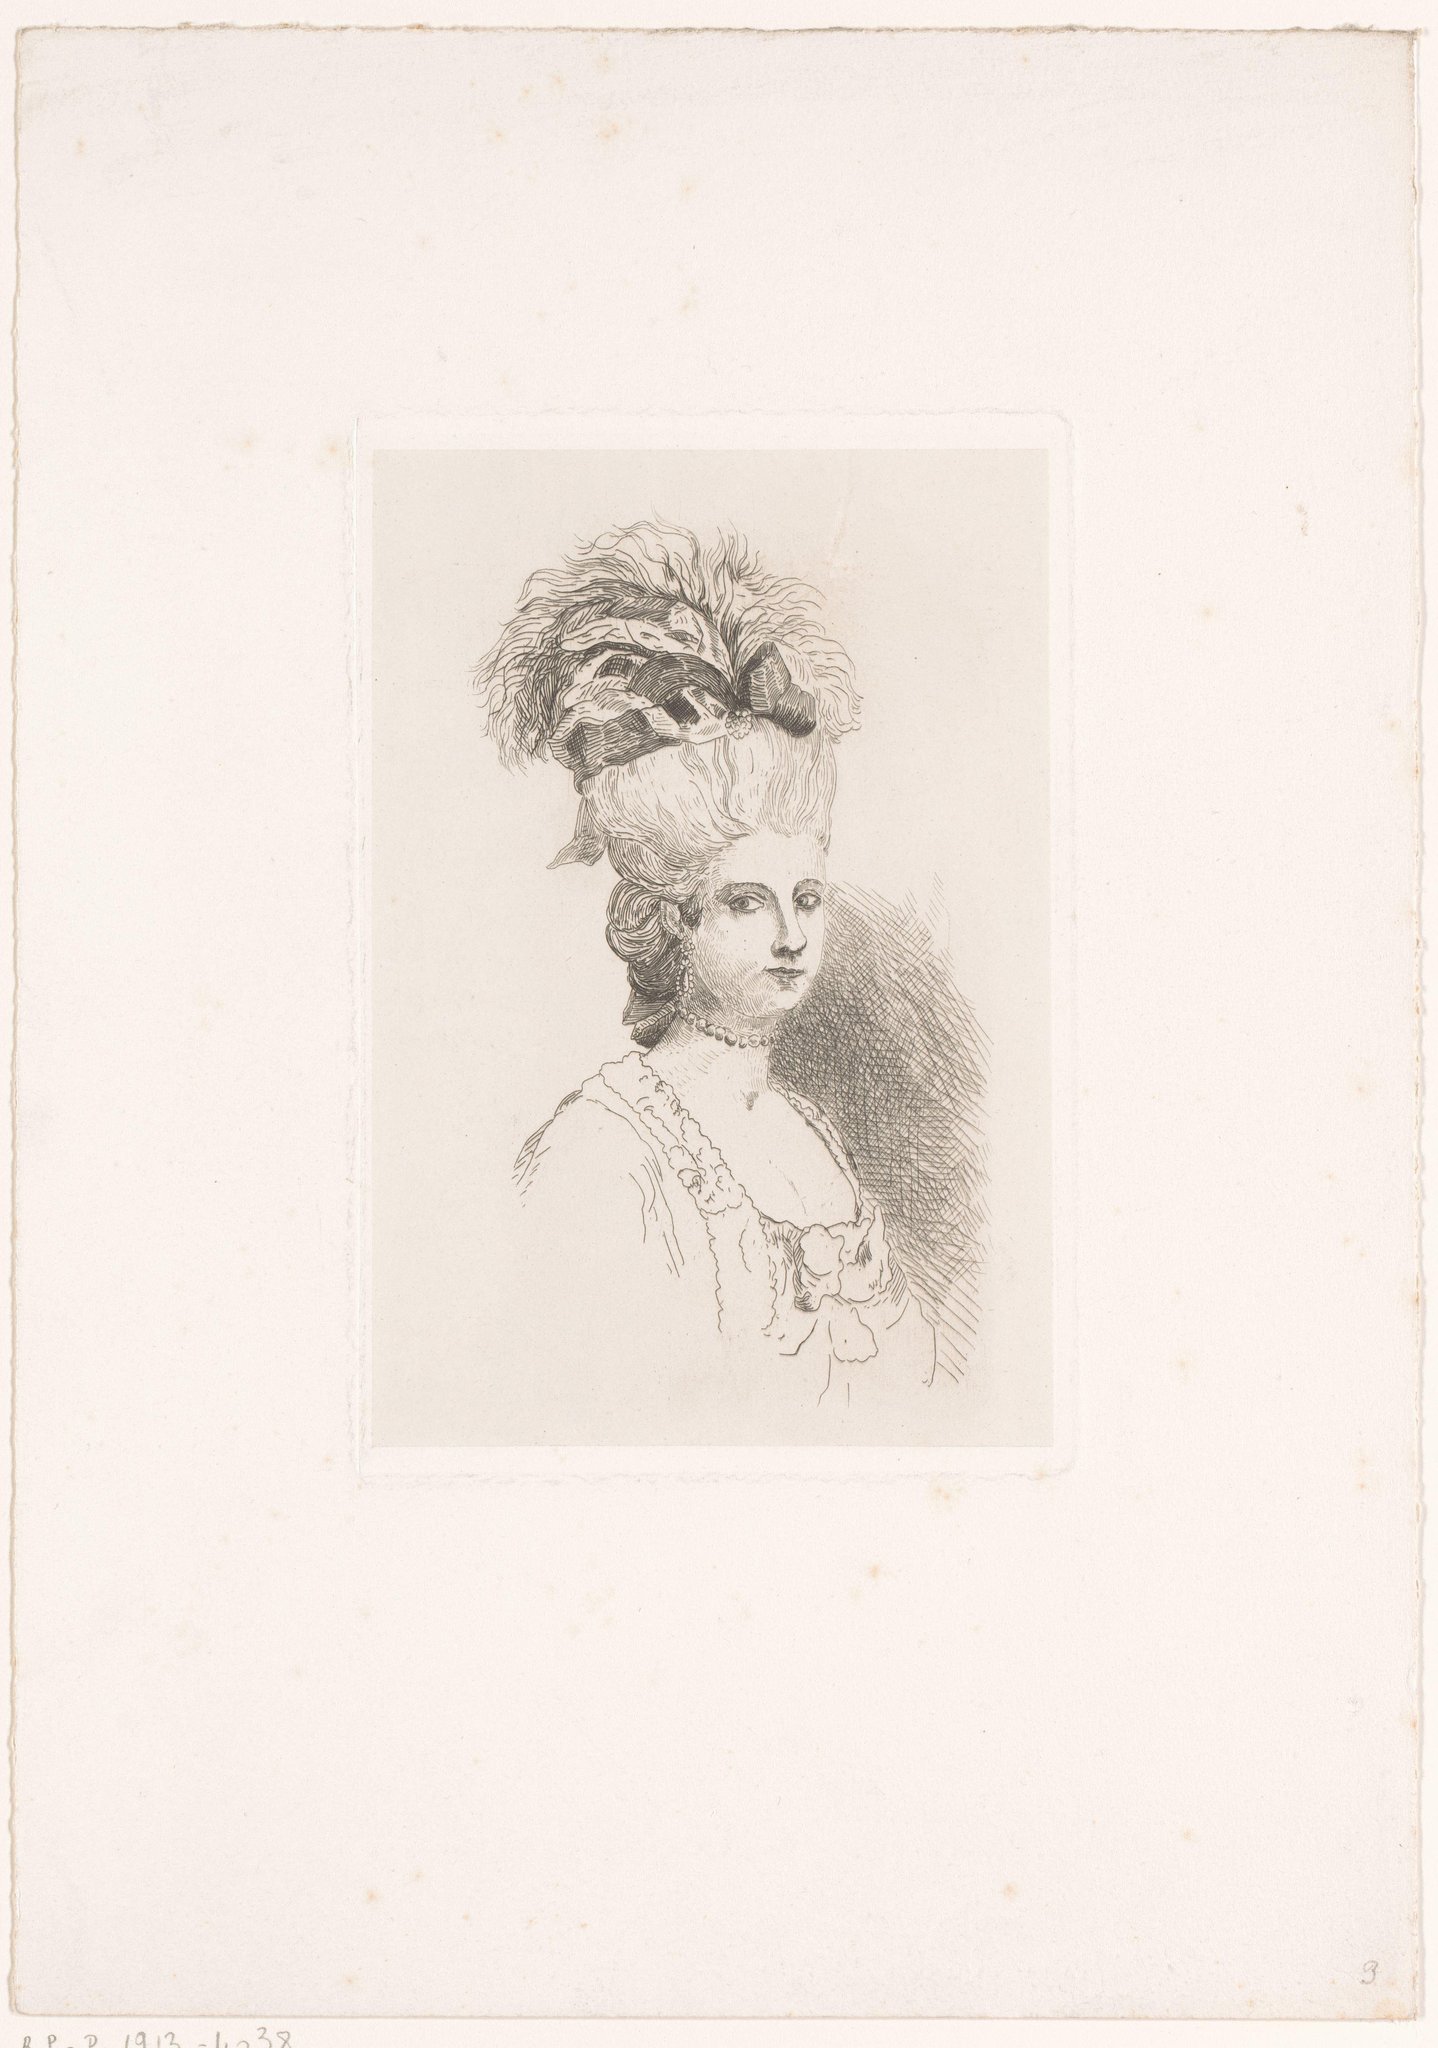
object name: print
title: Portret van een onbekende vrouw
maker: maria van hohenzollern-sigmaringen (gravin van vlaanderen)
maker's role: print maker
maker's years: 1845-1912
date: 1868-1912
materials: paper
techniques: etching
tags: historical persons not known by name - bb - woman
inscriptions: collector's mark: Lugt 2228